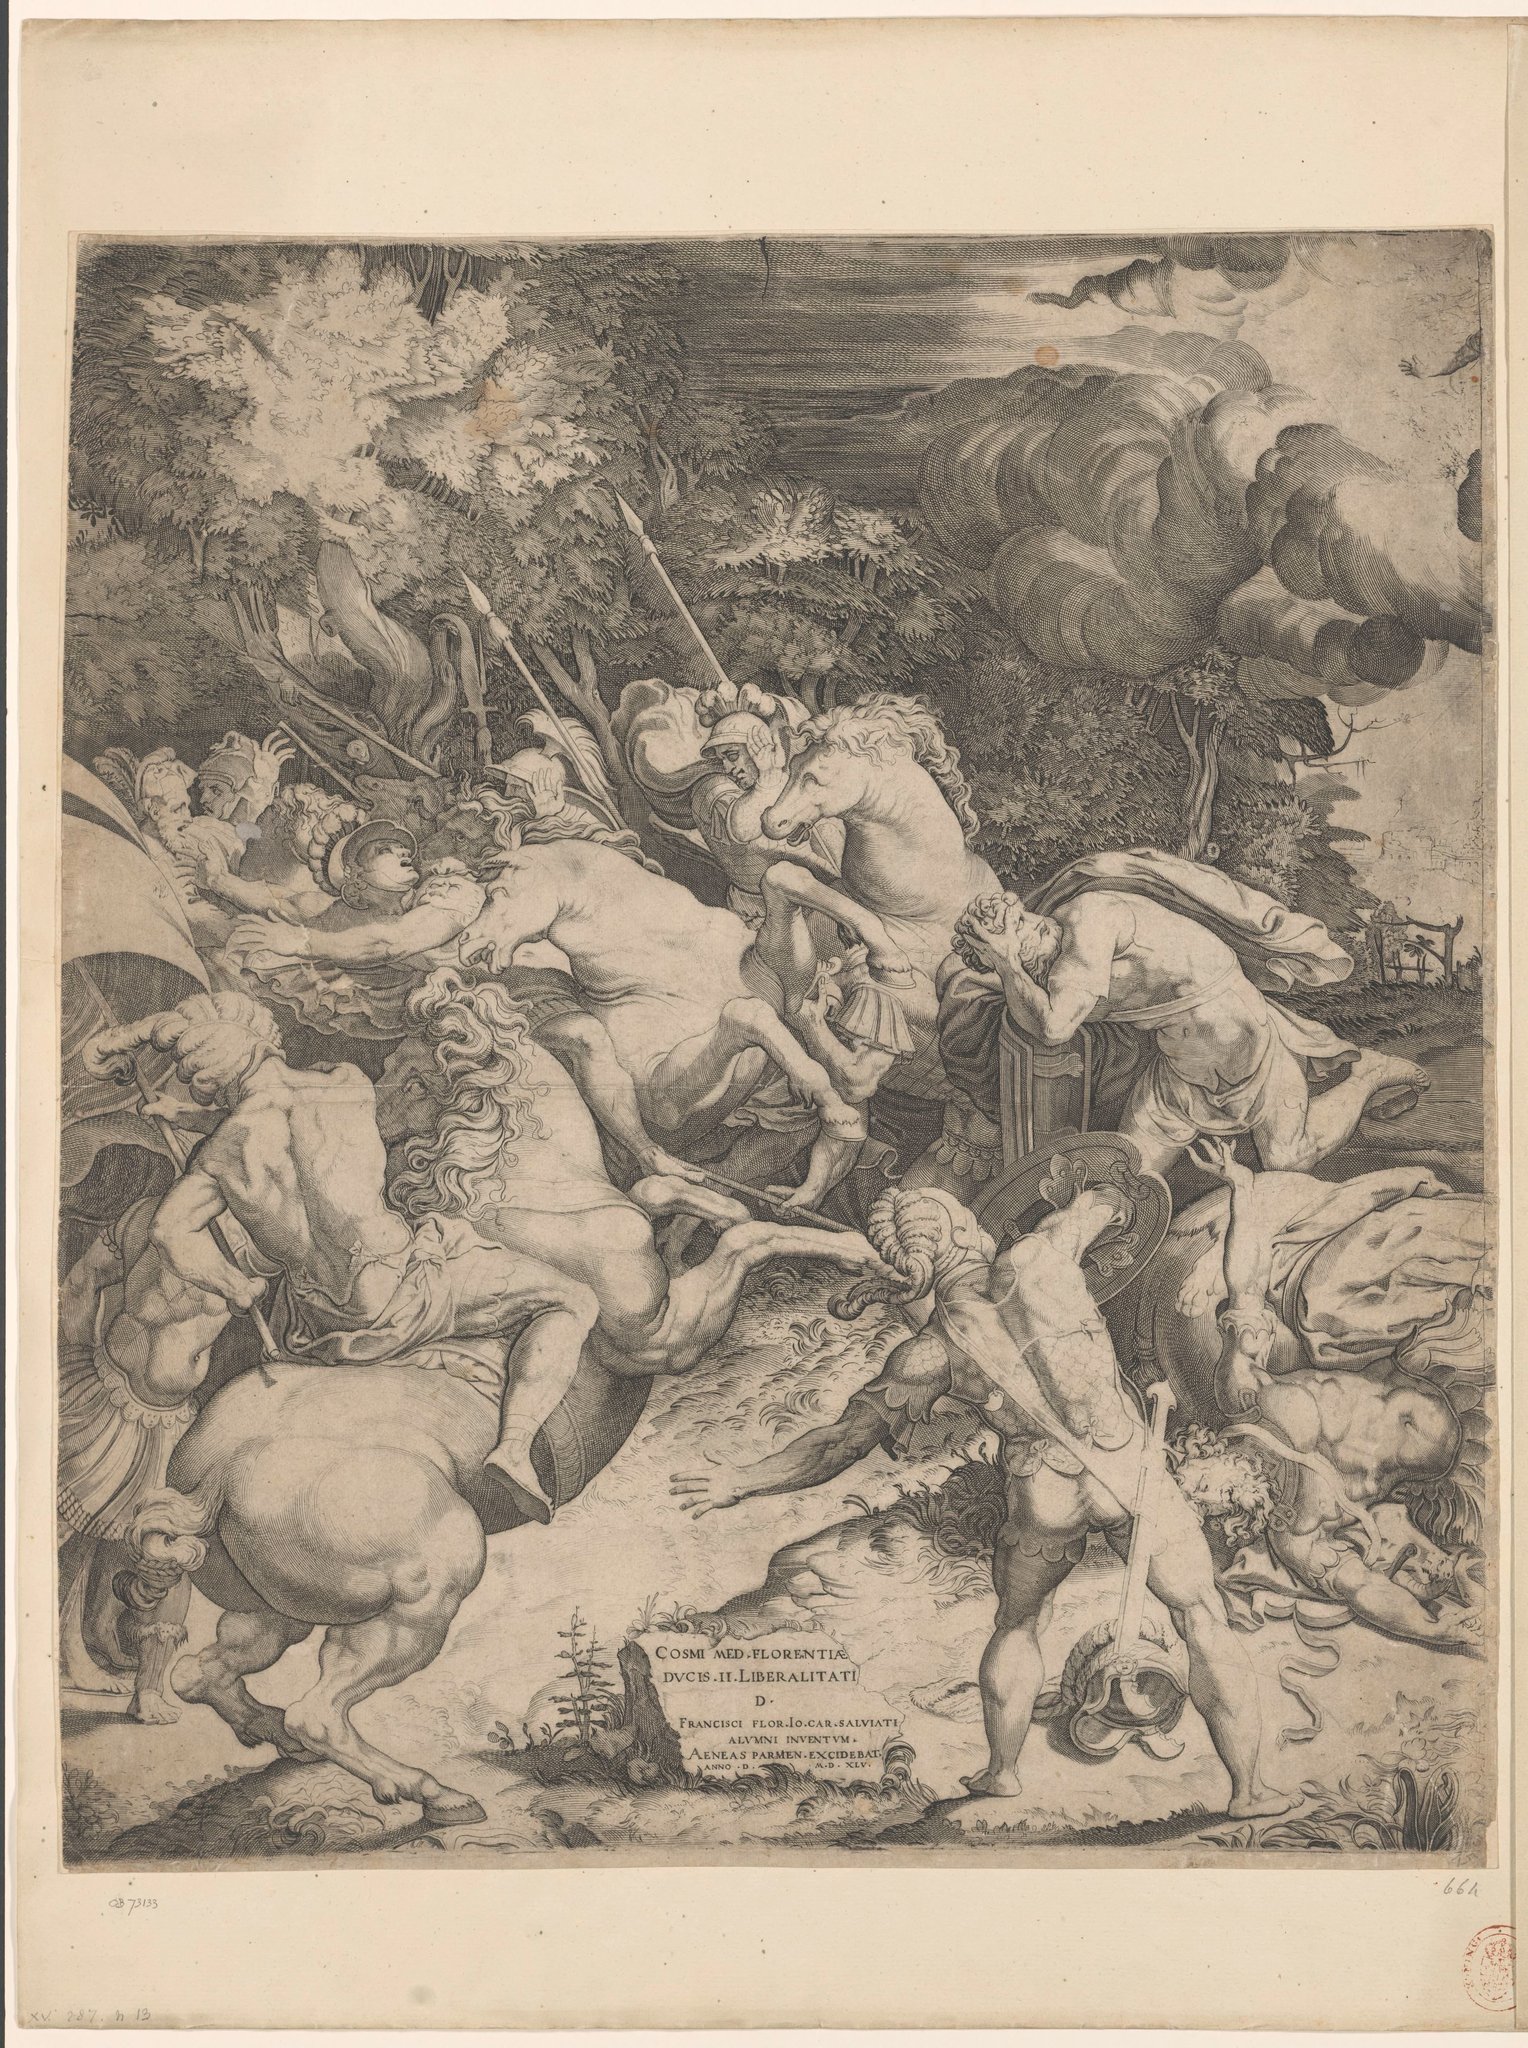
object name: print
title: Bekering van Paulus (linker blad)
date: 1545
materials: paper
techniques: engraving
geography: italy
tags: story of the conversion of paul (acts 9:1-18)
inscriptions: collector's mark: Lugt 240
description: Op weg naar Damascus valt Saulus geschrokken van zijn paard wanneer God aan hem verschijnt tussen de wolken. Zijn soldaten staan rondom hem in paniek. Op de achtergrond een landschap met ruïnes.